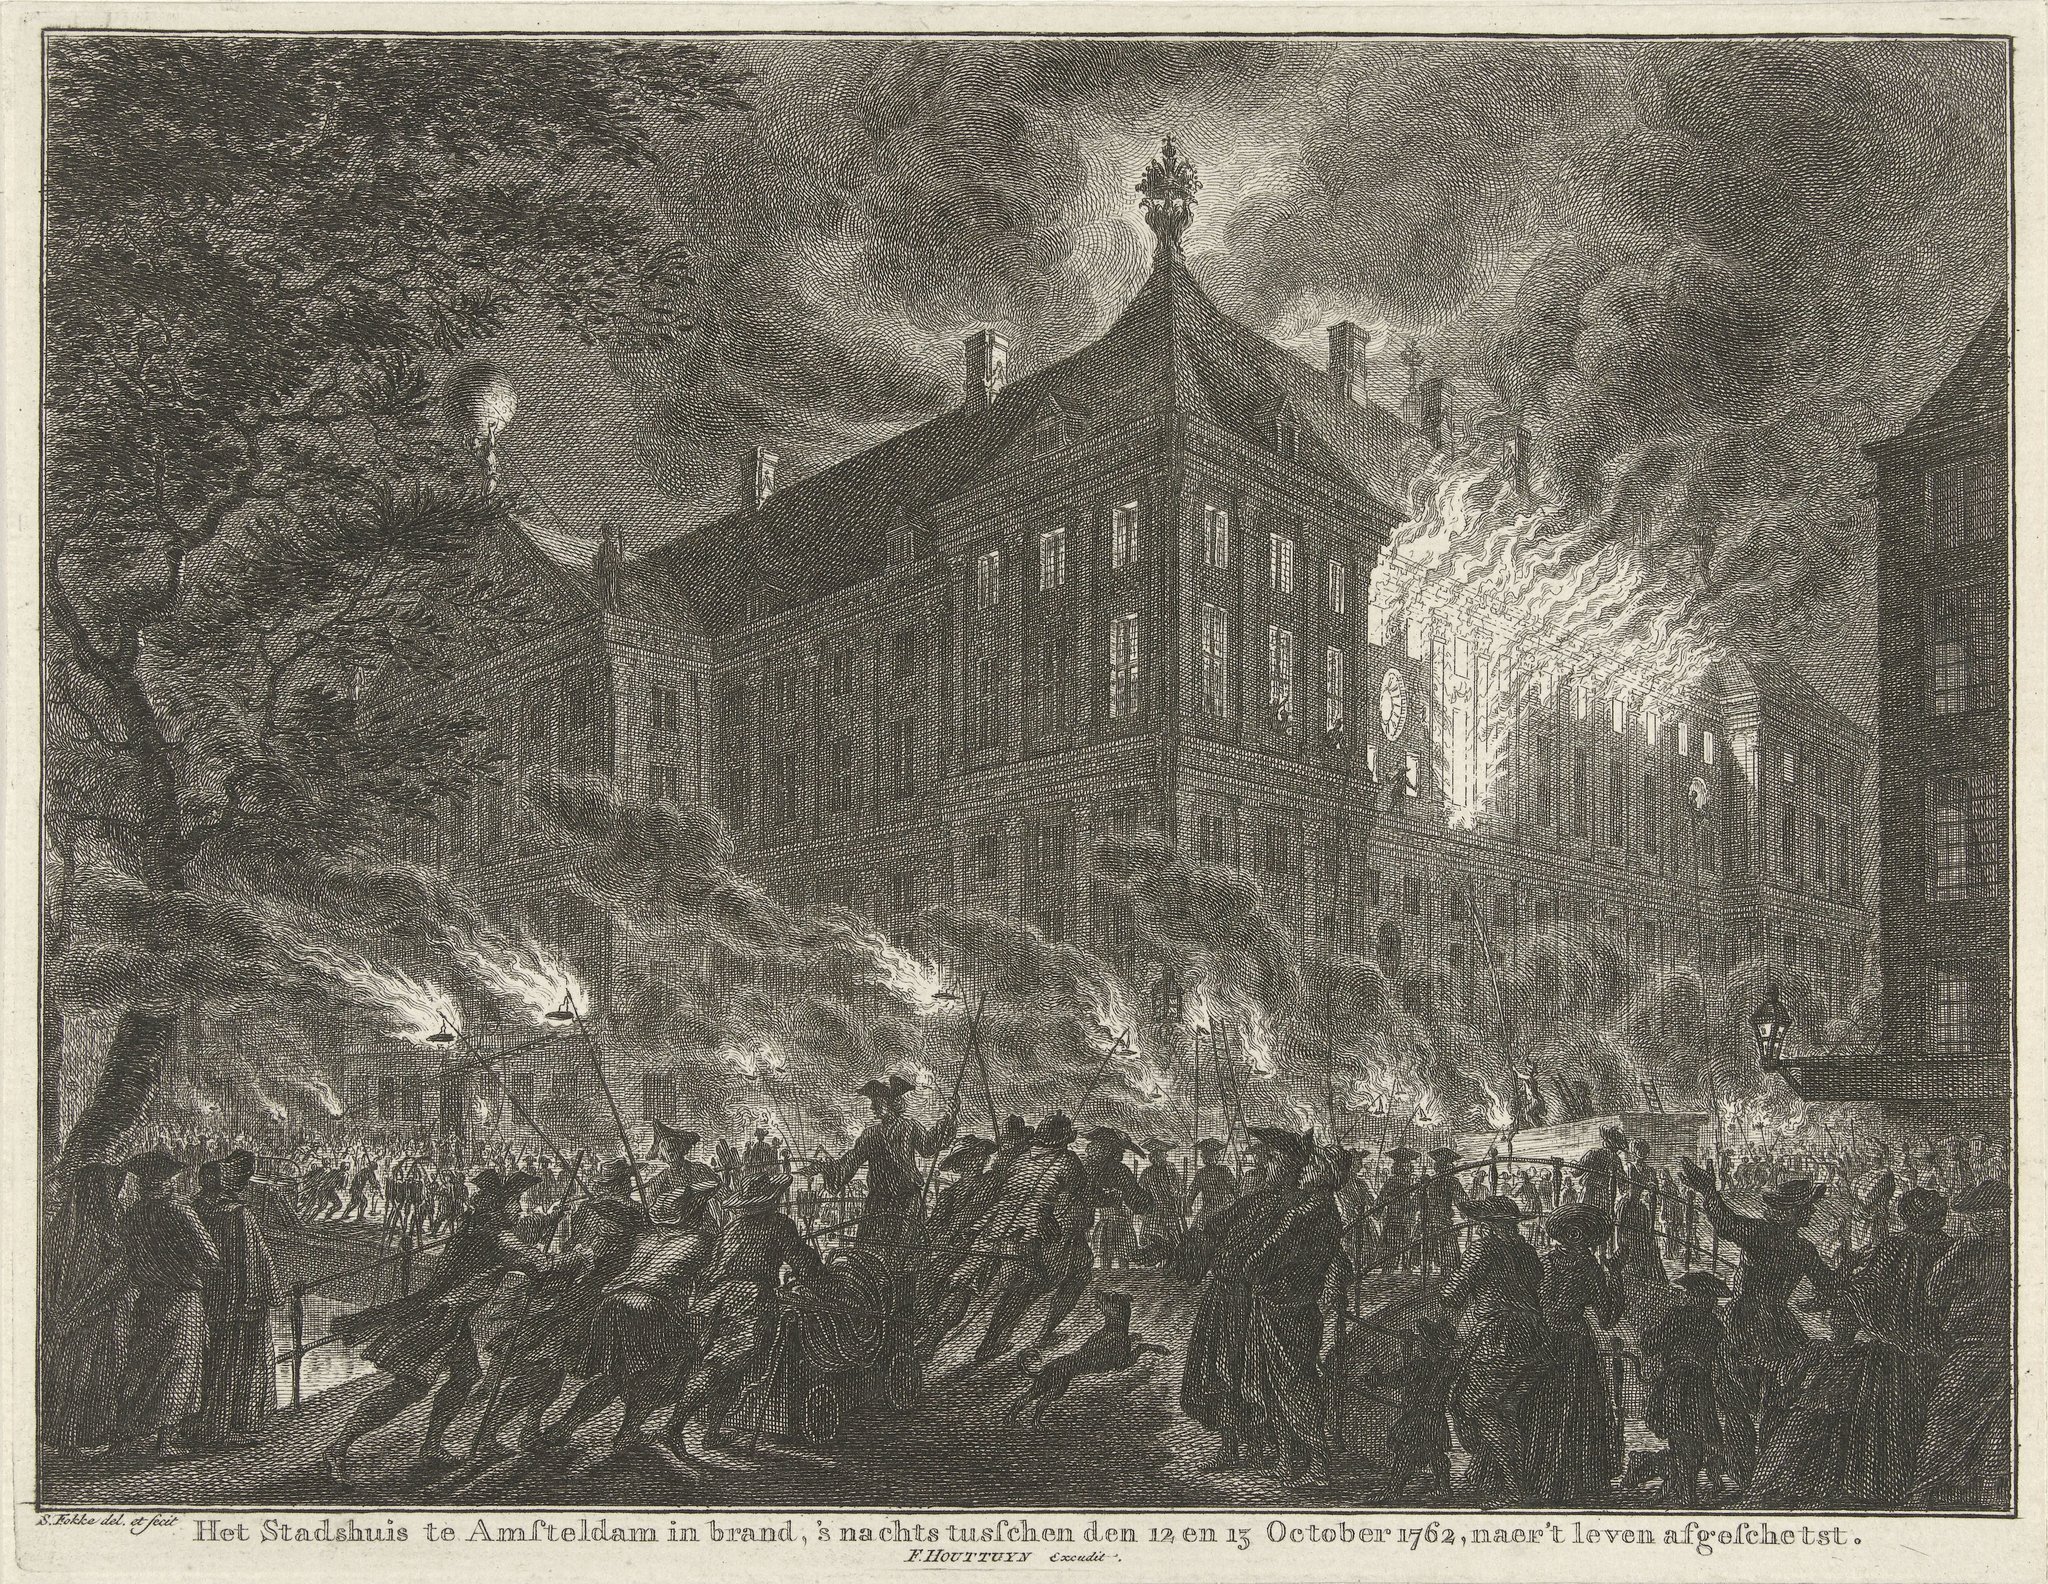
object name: book illustration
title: Brand in het stadhuis van Amsterdam, 1762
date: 1762-1763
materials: paper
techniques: engraving, etching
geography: amsterdam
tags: on fire, ablaze, townhall, fire-fighting, fire-extinguishing equipment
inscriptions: collector's mark: Lugt 2228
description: Huidige staat van prent ook gebruikt in: Nederlandsche Jaerboeken, inhoudende een verhael van de merkwaerdigste geschiedenissen (…) Zestiende deel. 1762. Amsterdam: Frans Houttuyn, s.a. [1762-1763].